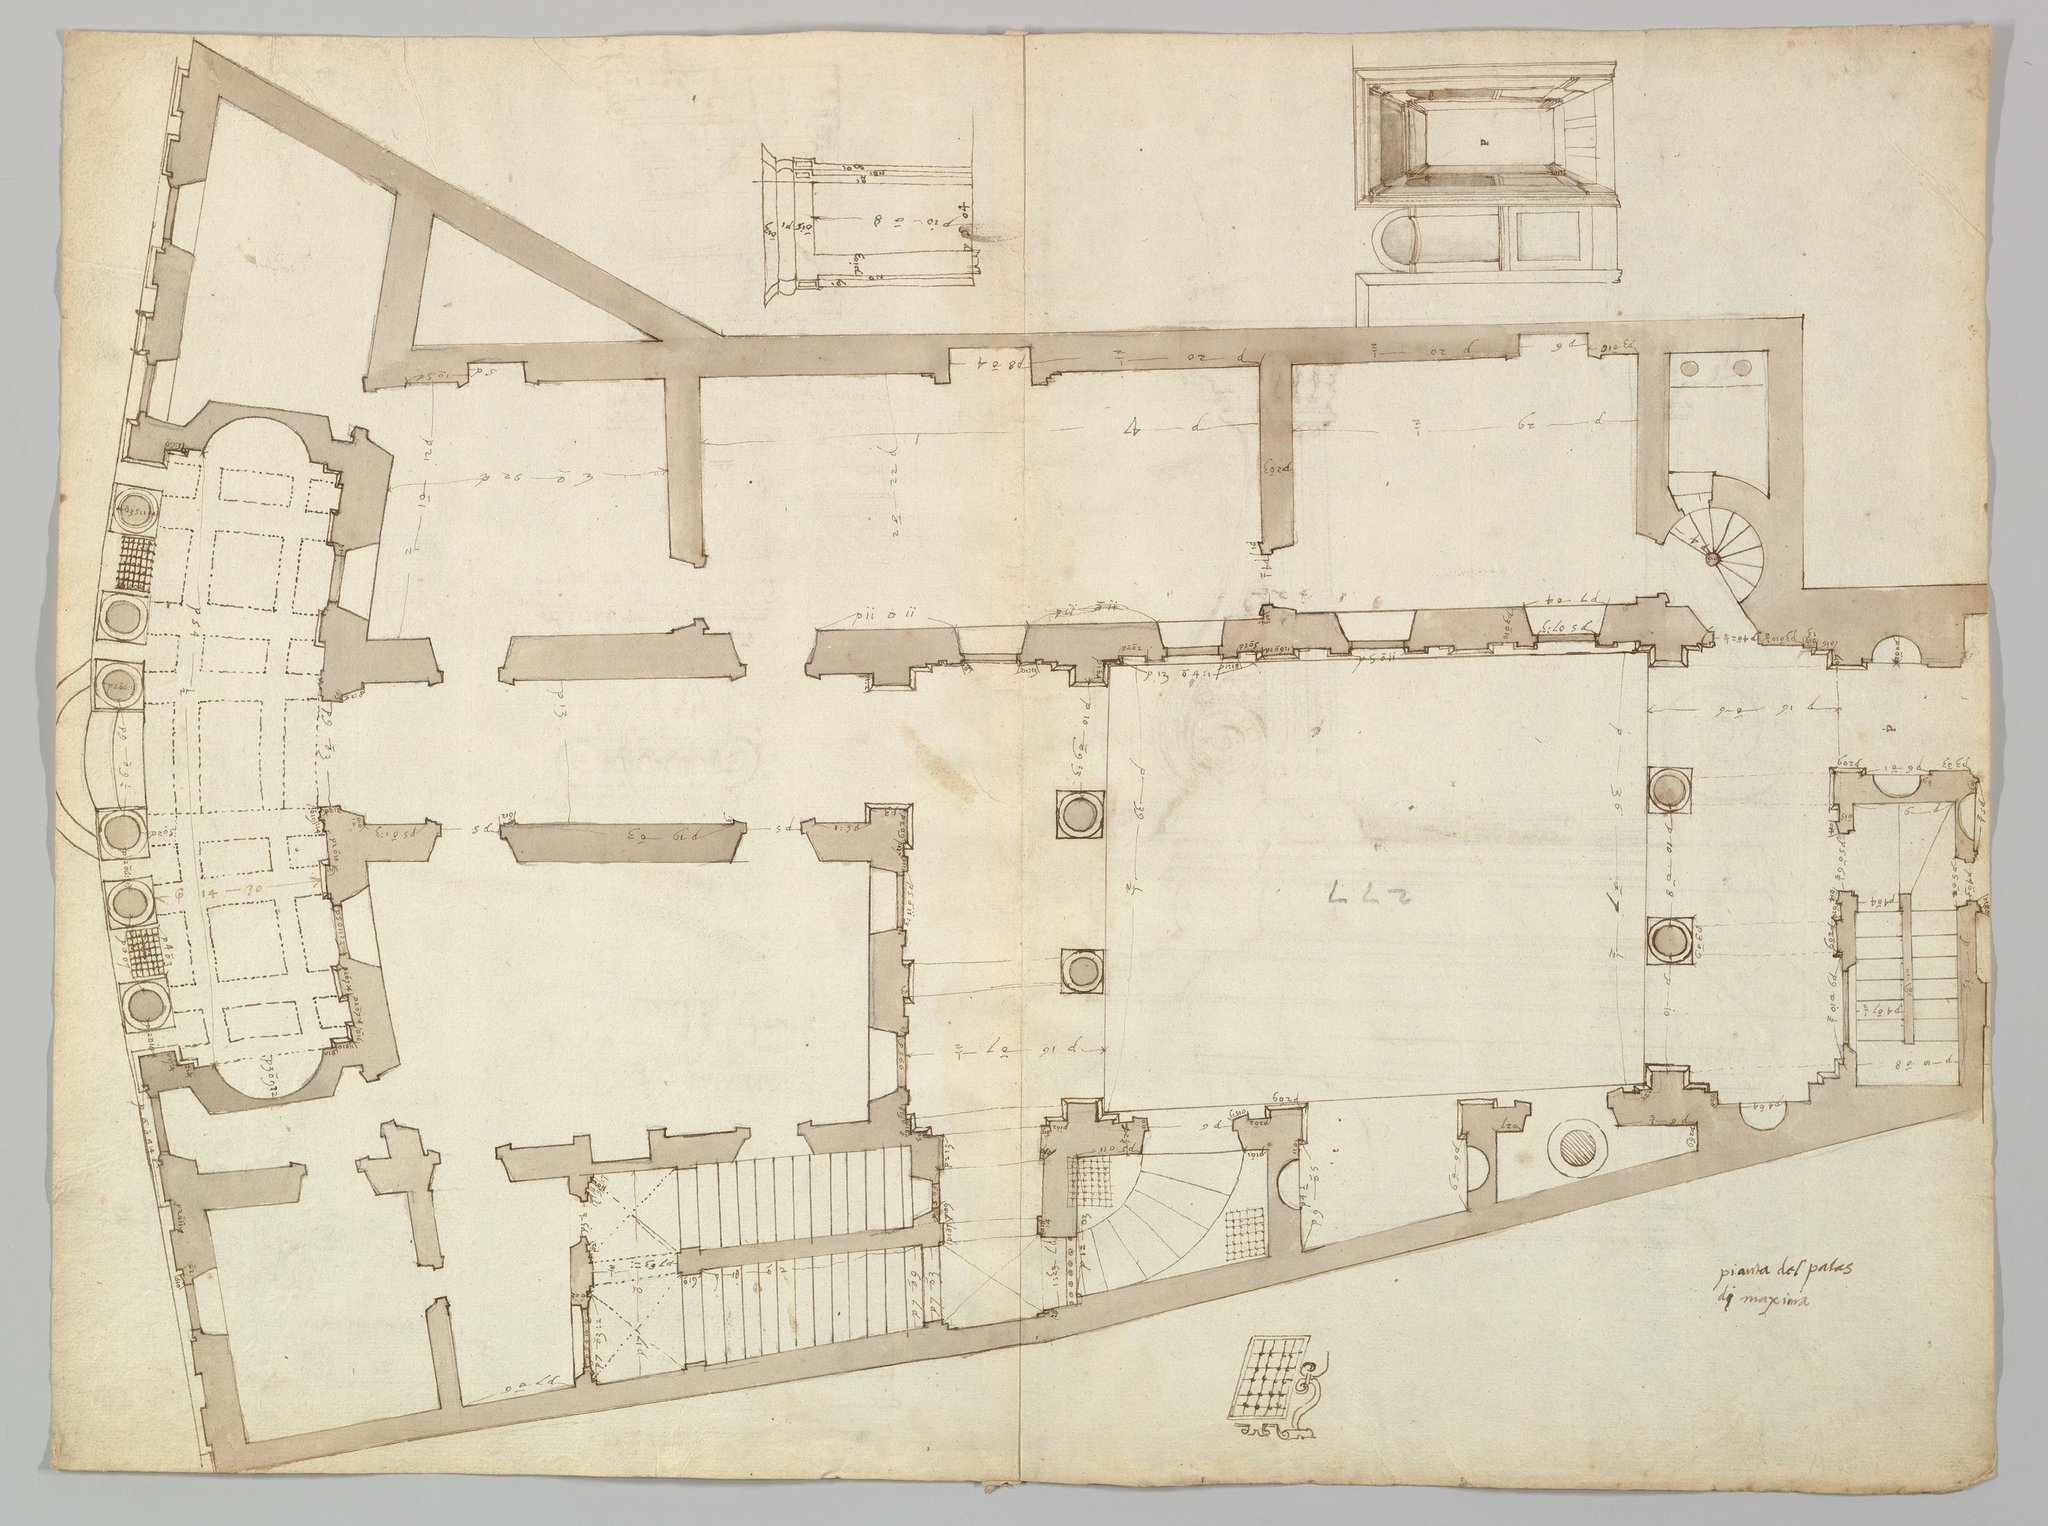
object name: drawing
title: Palazzo Massimo alle Colonne, plan (recto); Palazzo Massimo alle Colonne, façade, details and fireplace (verso)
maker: anonymous, french, 16th century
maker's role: draftsman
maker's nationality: french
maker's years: 1500-1600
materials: chalk, ink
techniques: incising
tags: architecture